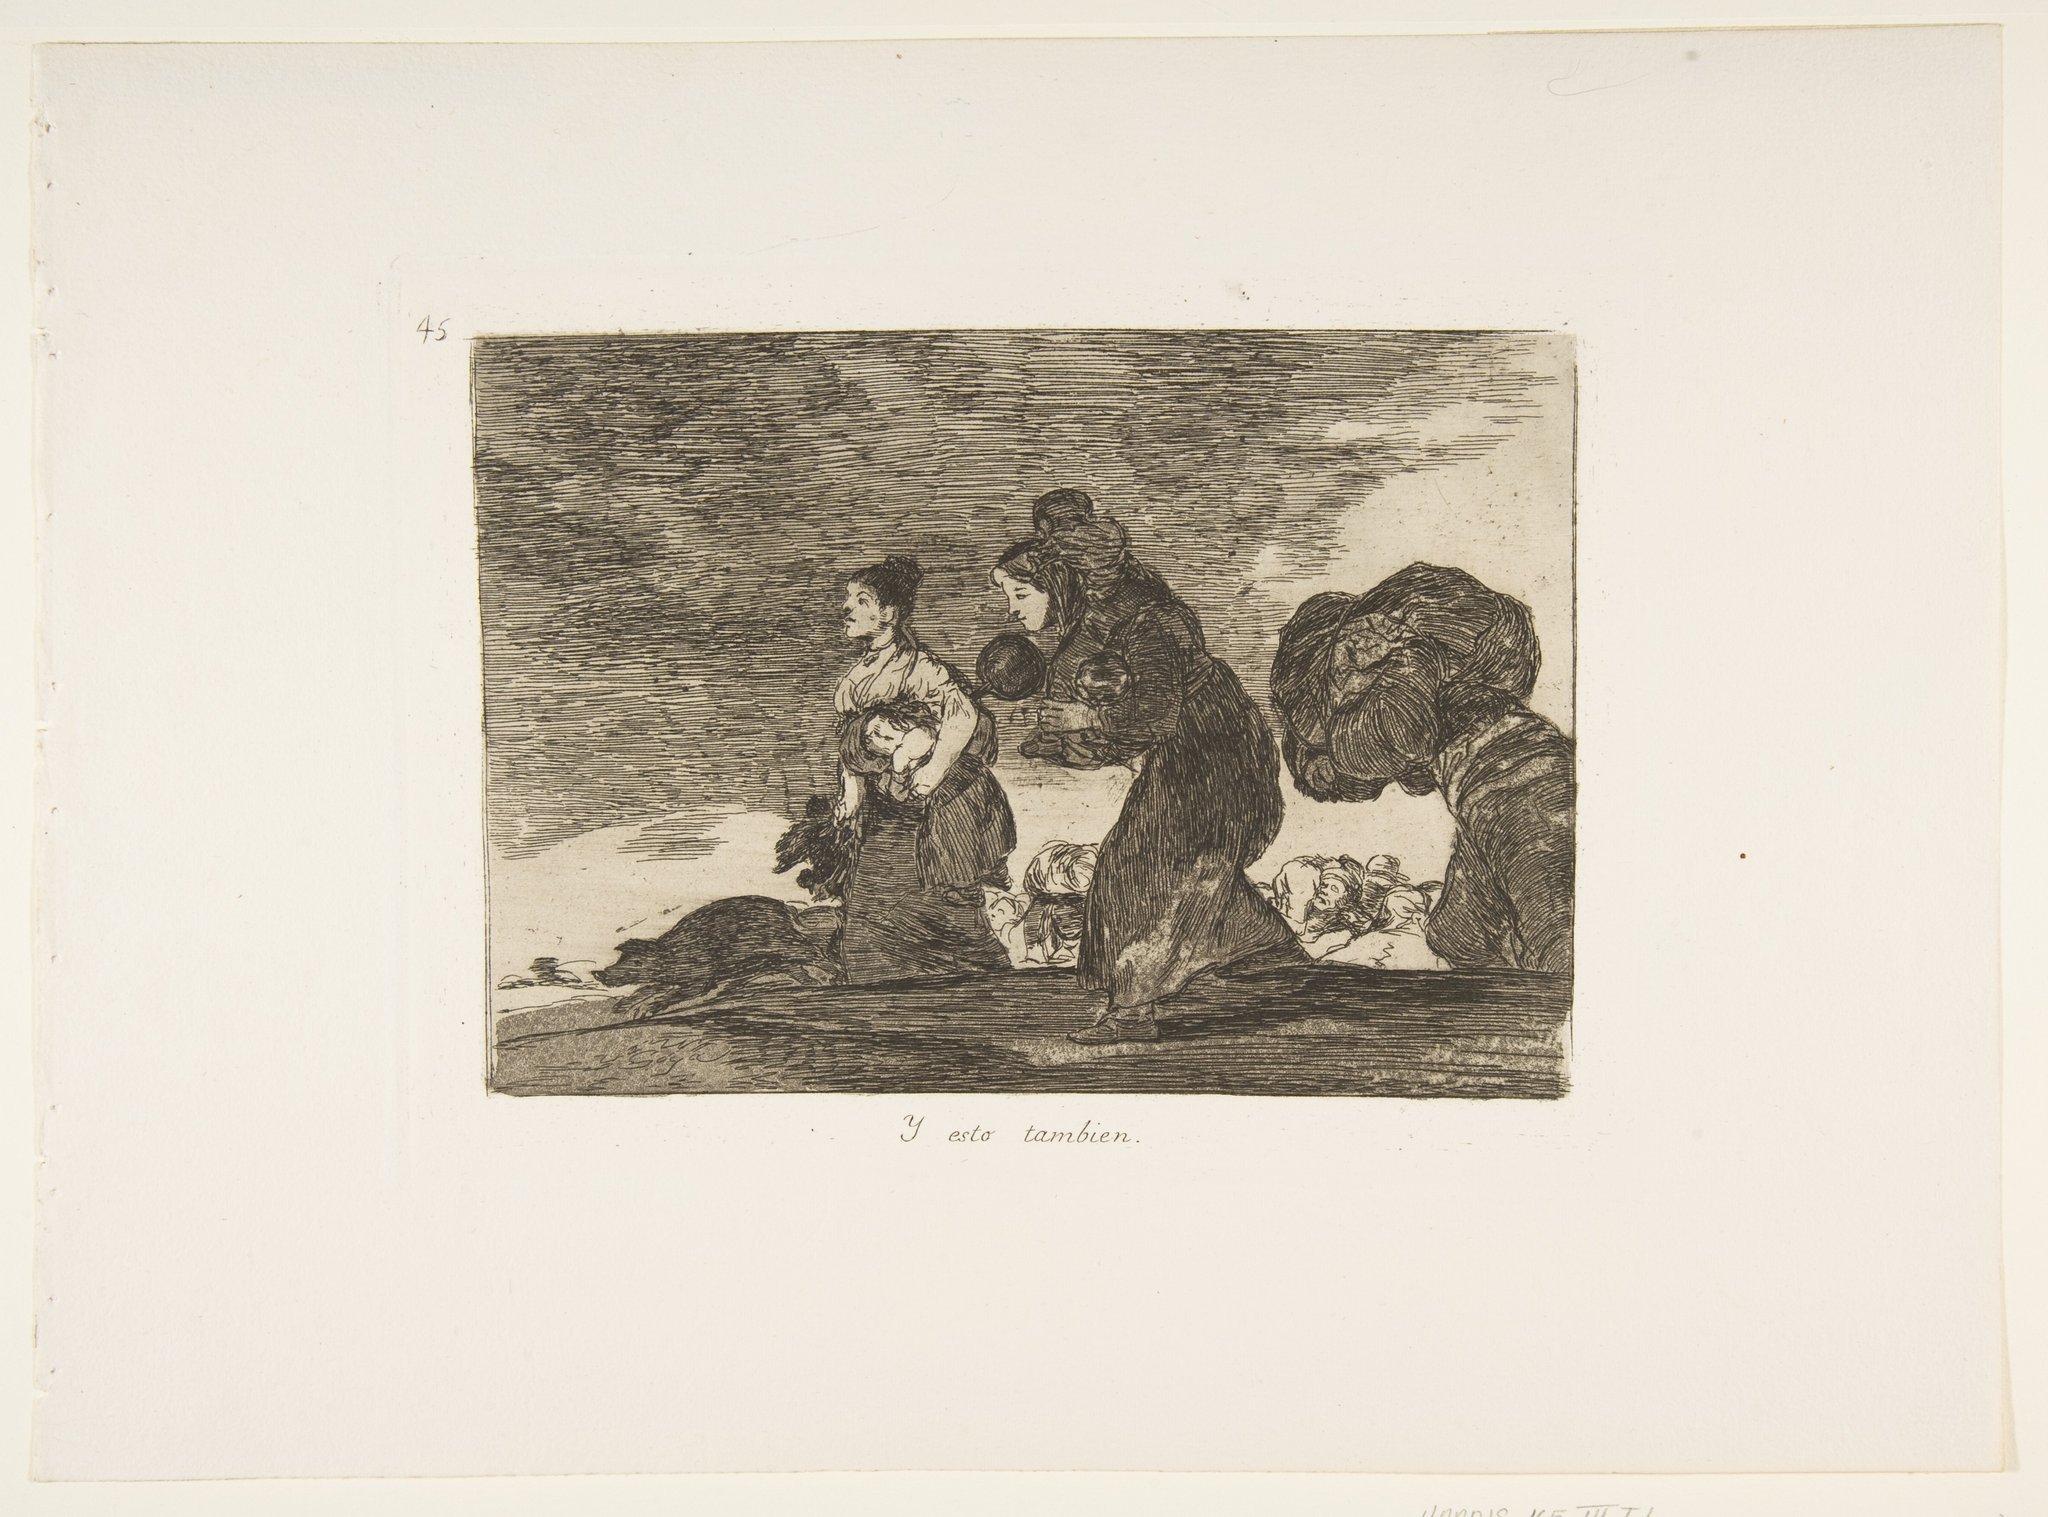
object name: print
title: Plate 45 from "The Disasters of War" (Los Desastres de la Guerra): 'And this too' (Y esto tambien)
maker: goya (francisco de goya y lucientes)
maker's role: artist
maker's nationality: spanish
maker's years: 1746-1828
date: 1810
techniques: aquatint, engraving, drypoint, etching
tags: suffering,infants,women,pigs